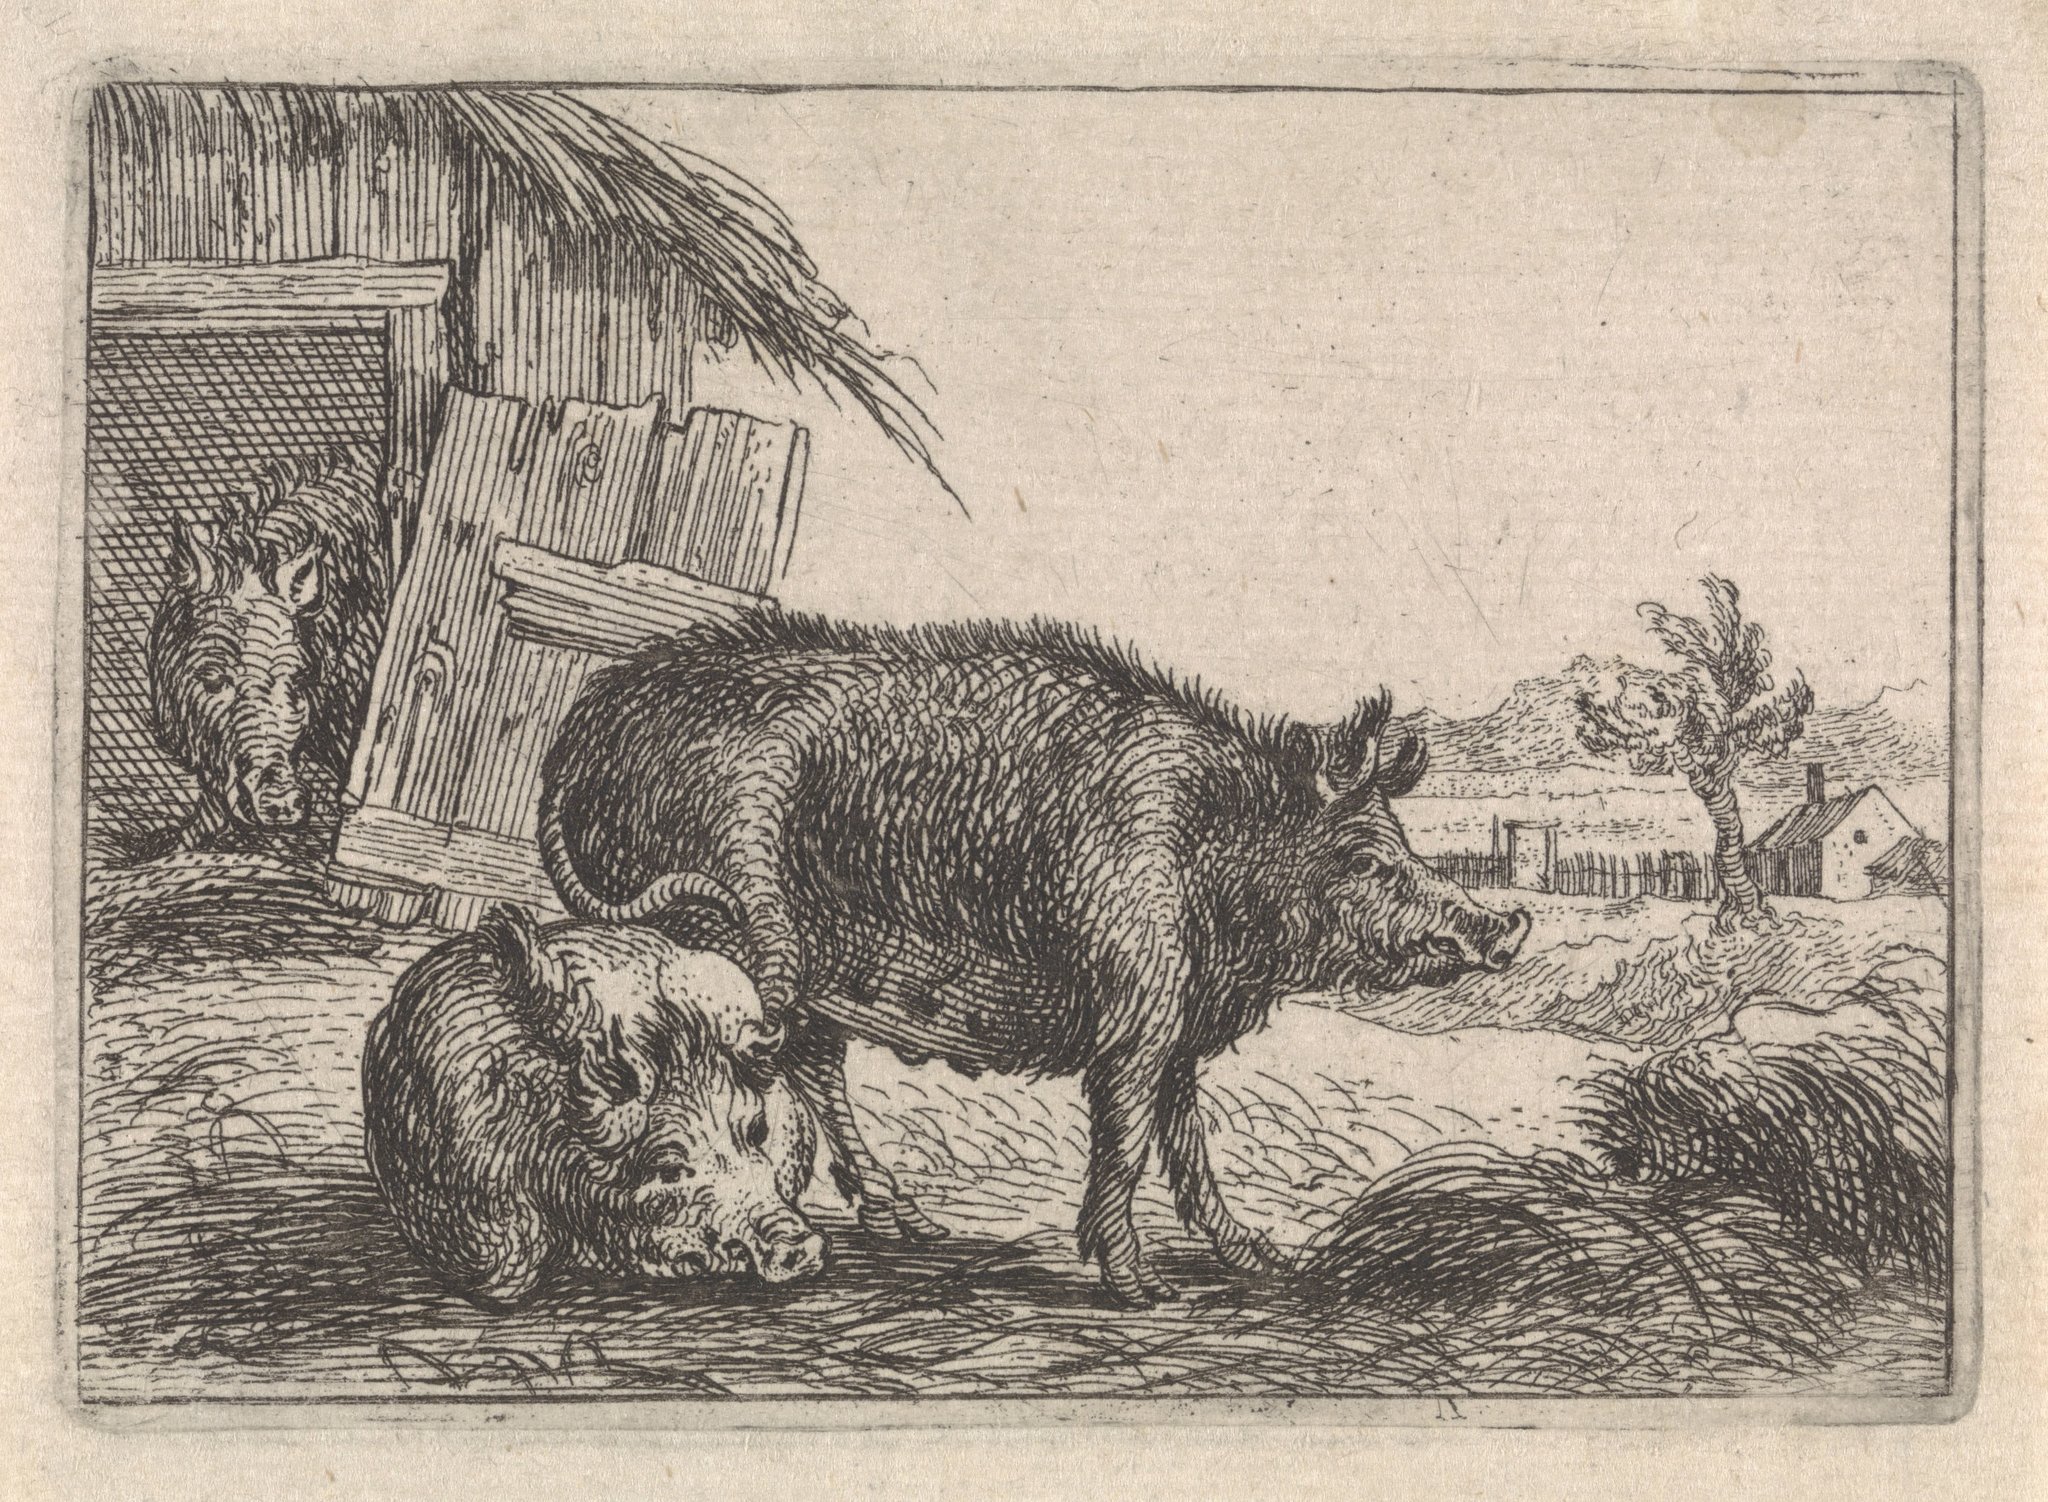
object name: print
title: Drie zwijnen bij een stal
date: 1654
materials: paper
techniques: etching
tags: boar (male pig), stall, stable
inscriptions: collector's mark: Lugt 2228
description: Voor een stal waar een zwijn in zit zijn twee zwijnen afgebeeld, waarvan er een staat en een ligt. Op de achtergrond is een boerenhoeve te zien. Deze prent maakt deel uit van een tiendelige serie over diverse dieren.